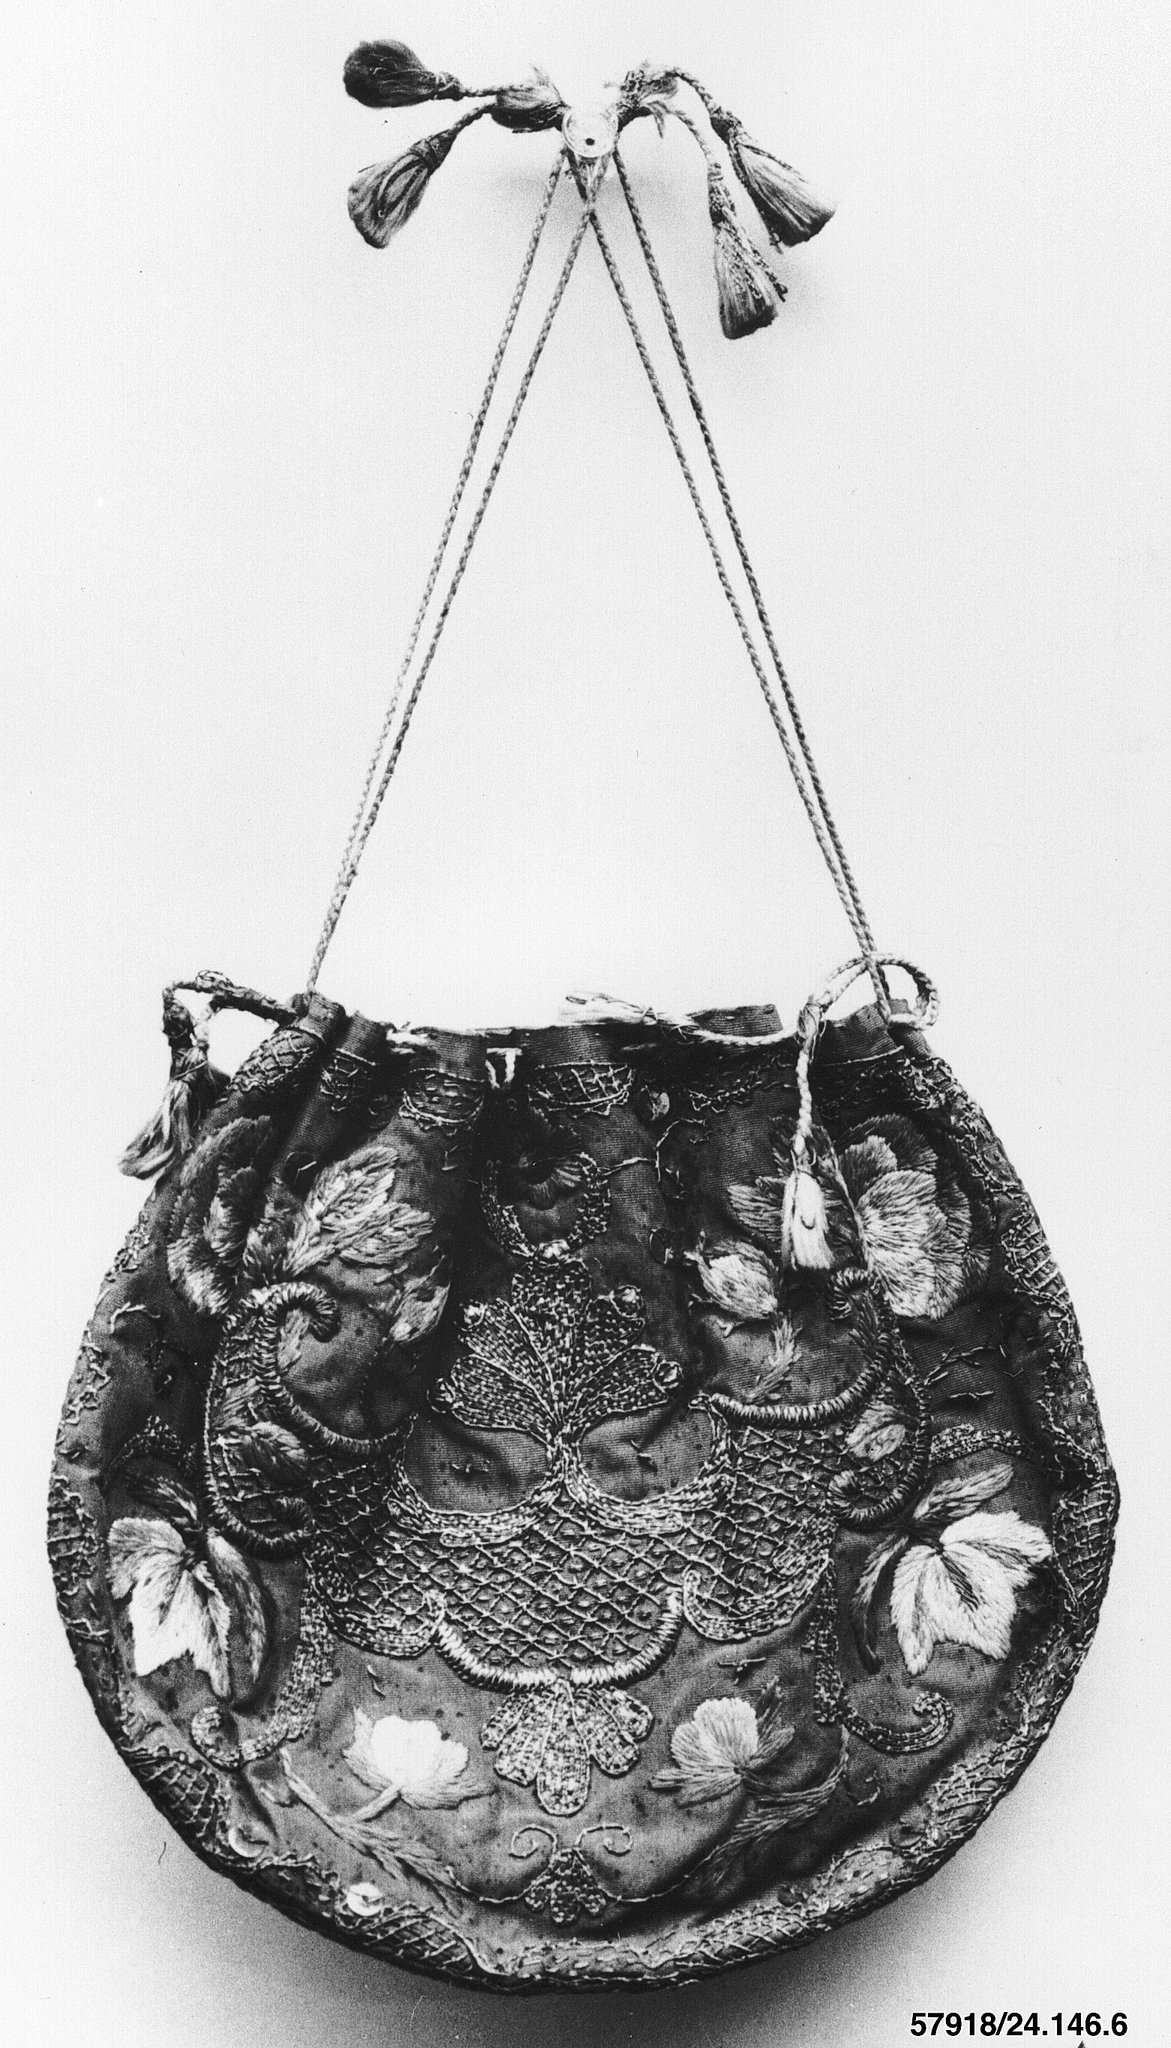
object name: bag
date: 1667-1700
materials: metal thread, silk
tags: flowers